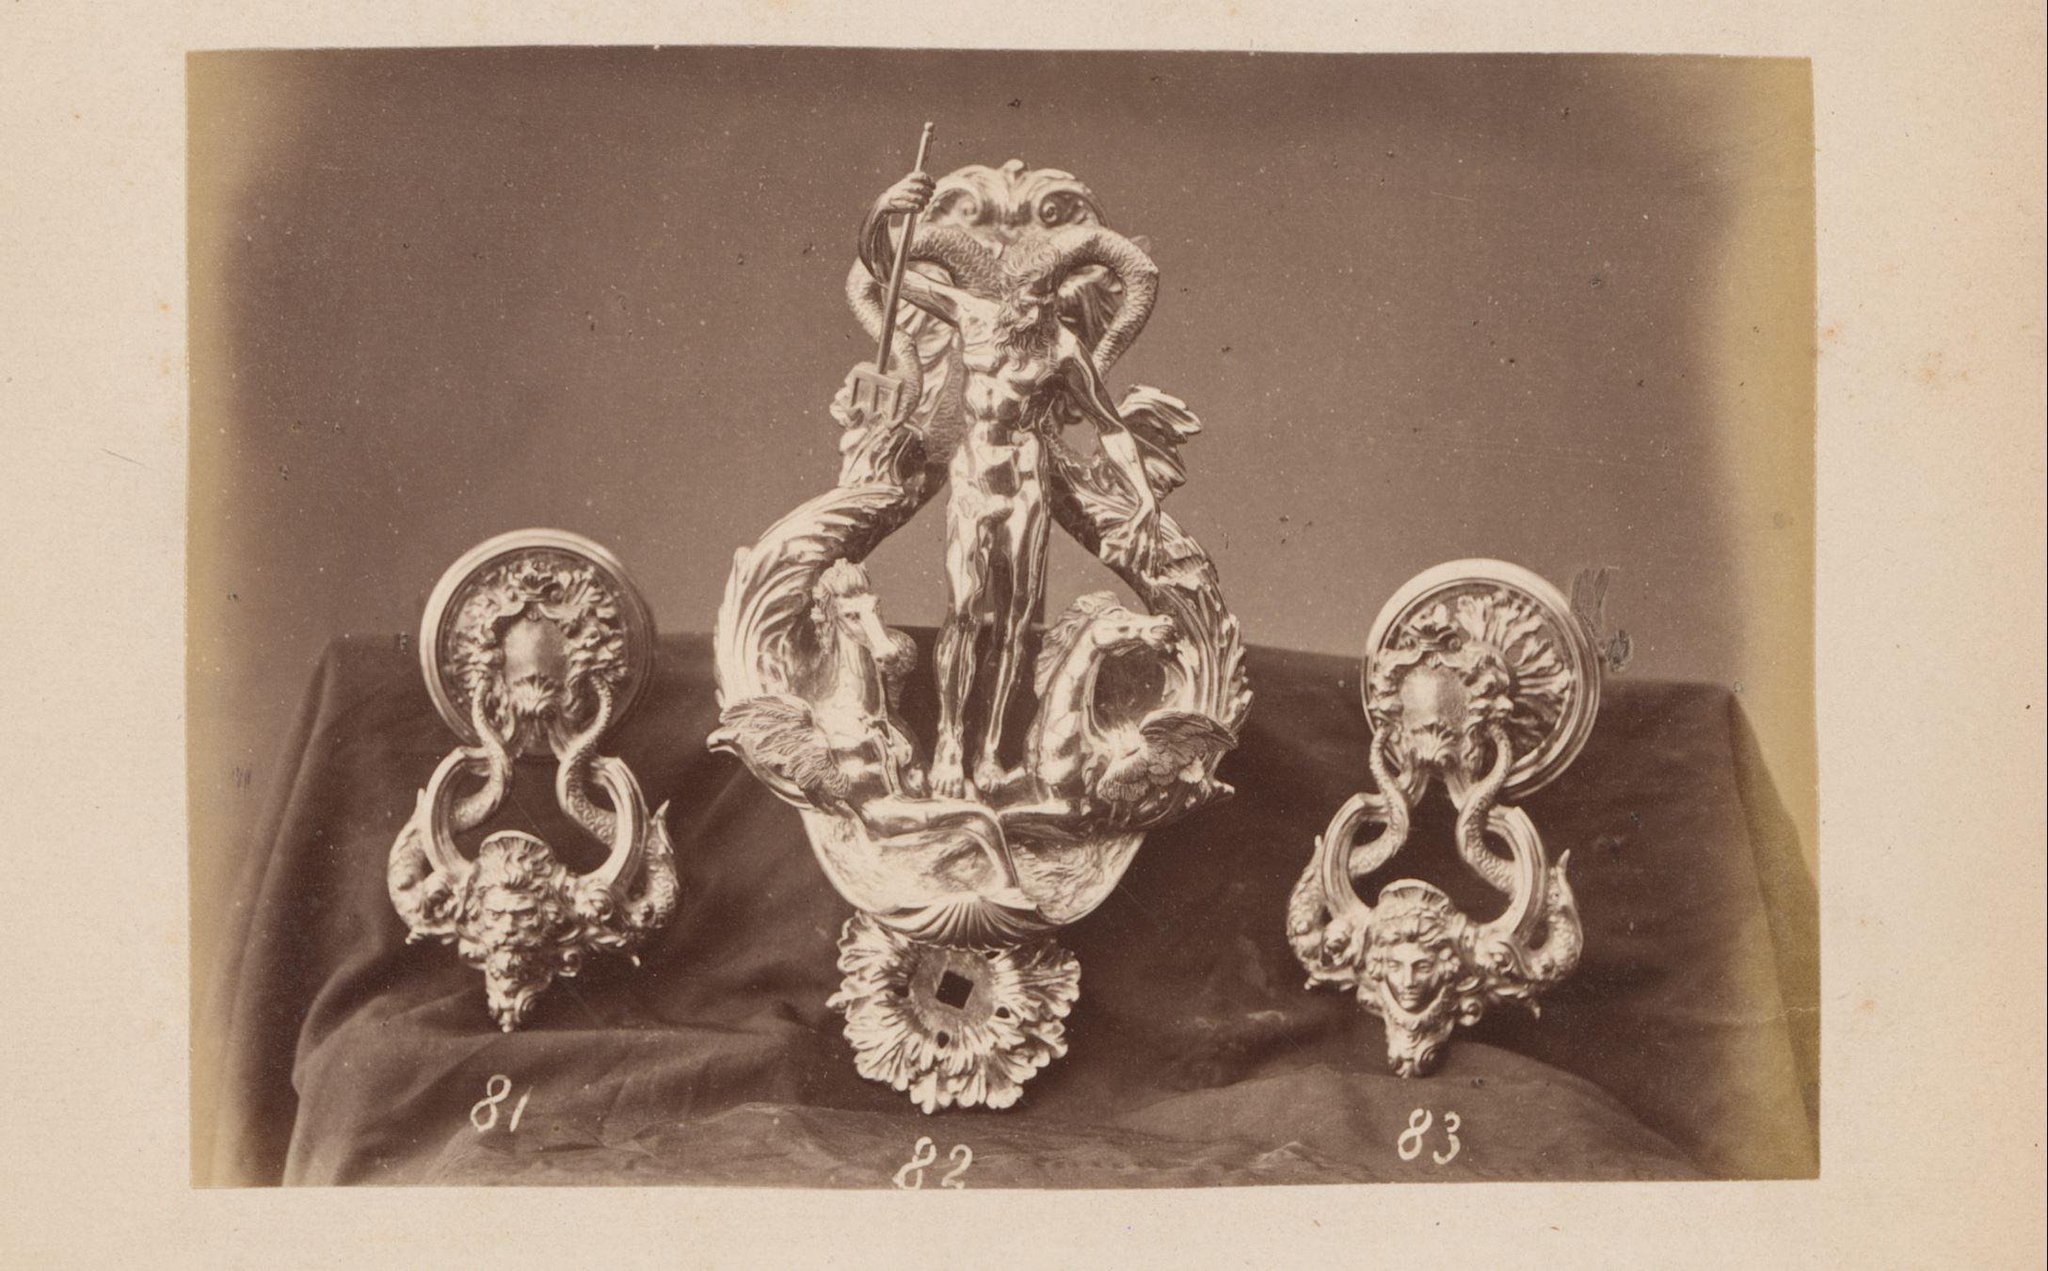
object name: photograph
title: Metalen deurkloppers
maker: Anonymous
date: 1860-1885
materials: photographic support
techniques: albumen print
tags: door-knocker, doorbell